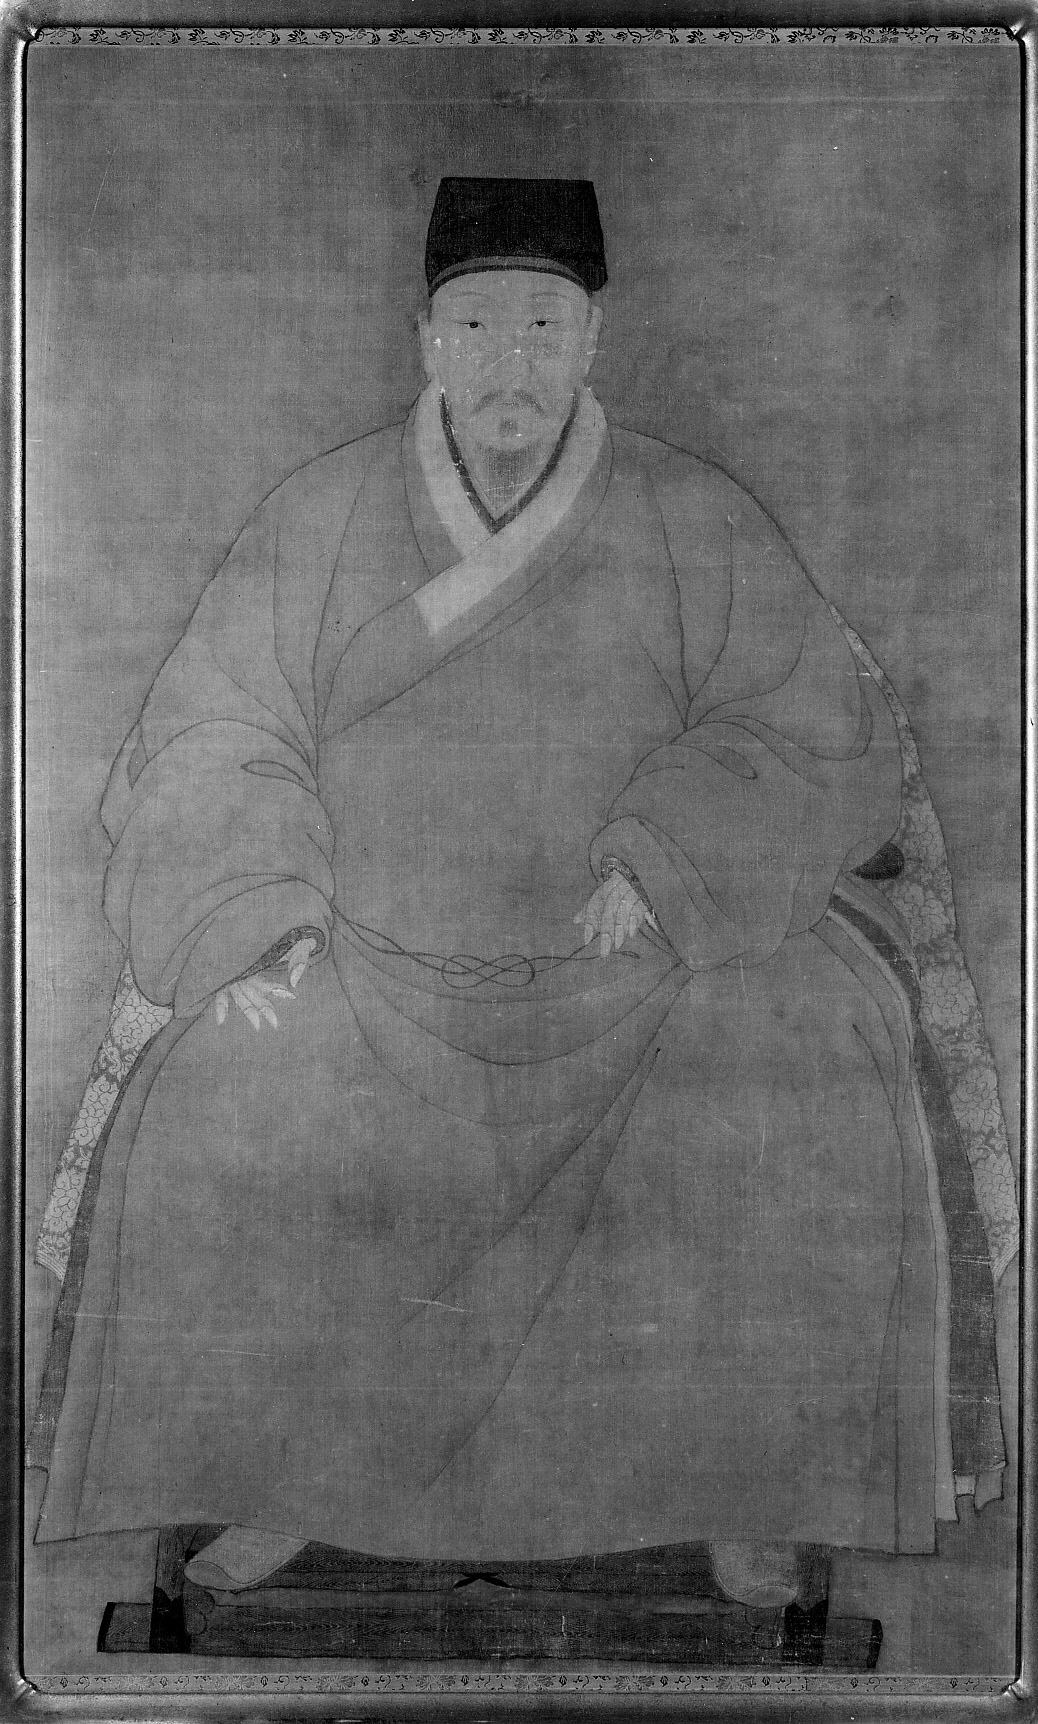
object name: framed painting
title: Portrait of a Gentleman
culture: chinese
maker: unidentified artist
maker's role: artist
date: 1567-1633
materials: ink, silk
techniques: painting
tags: men,portraits